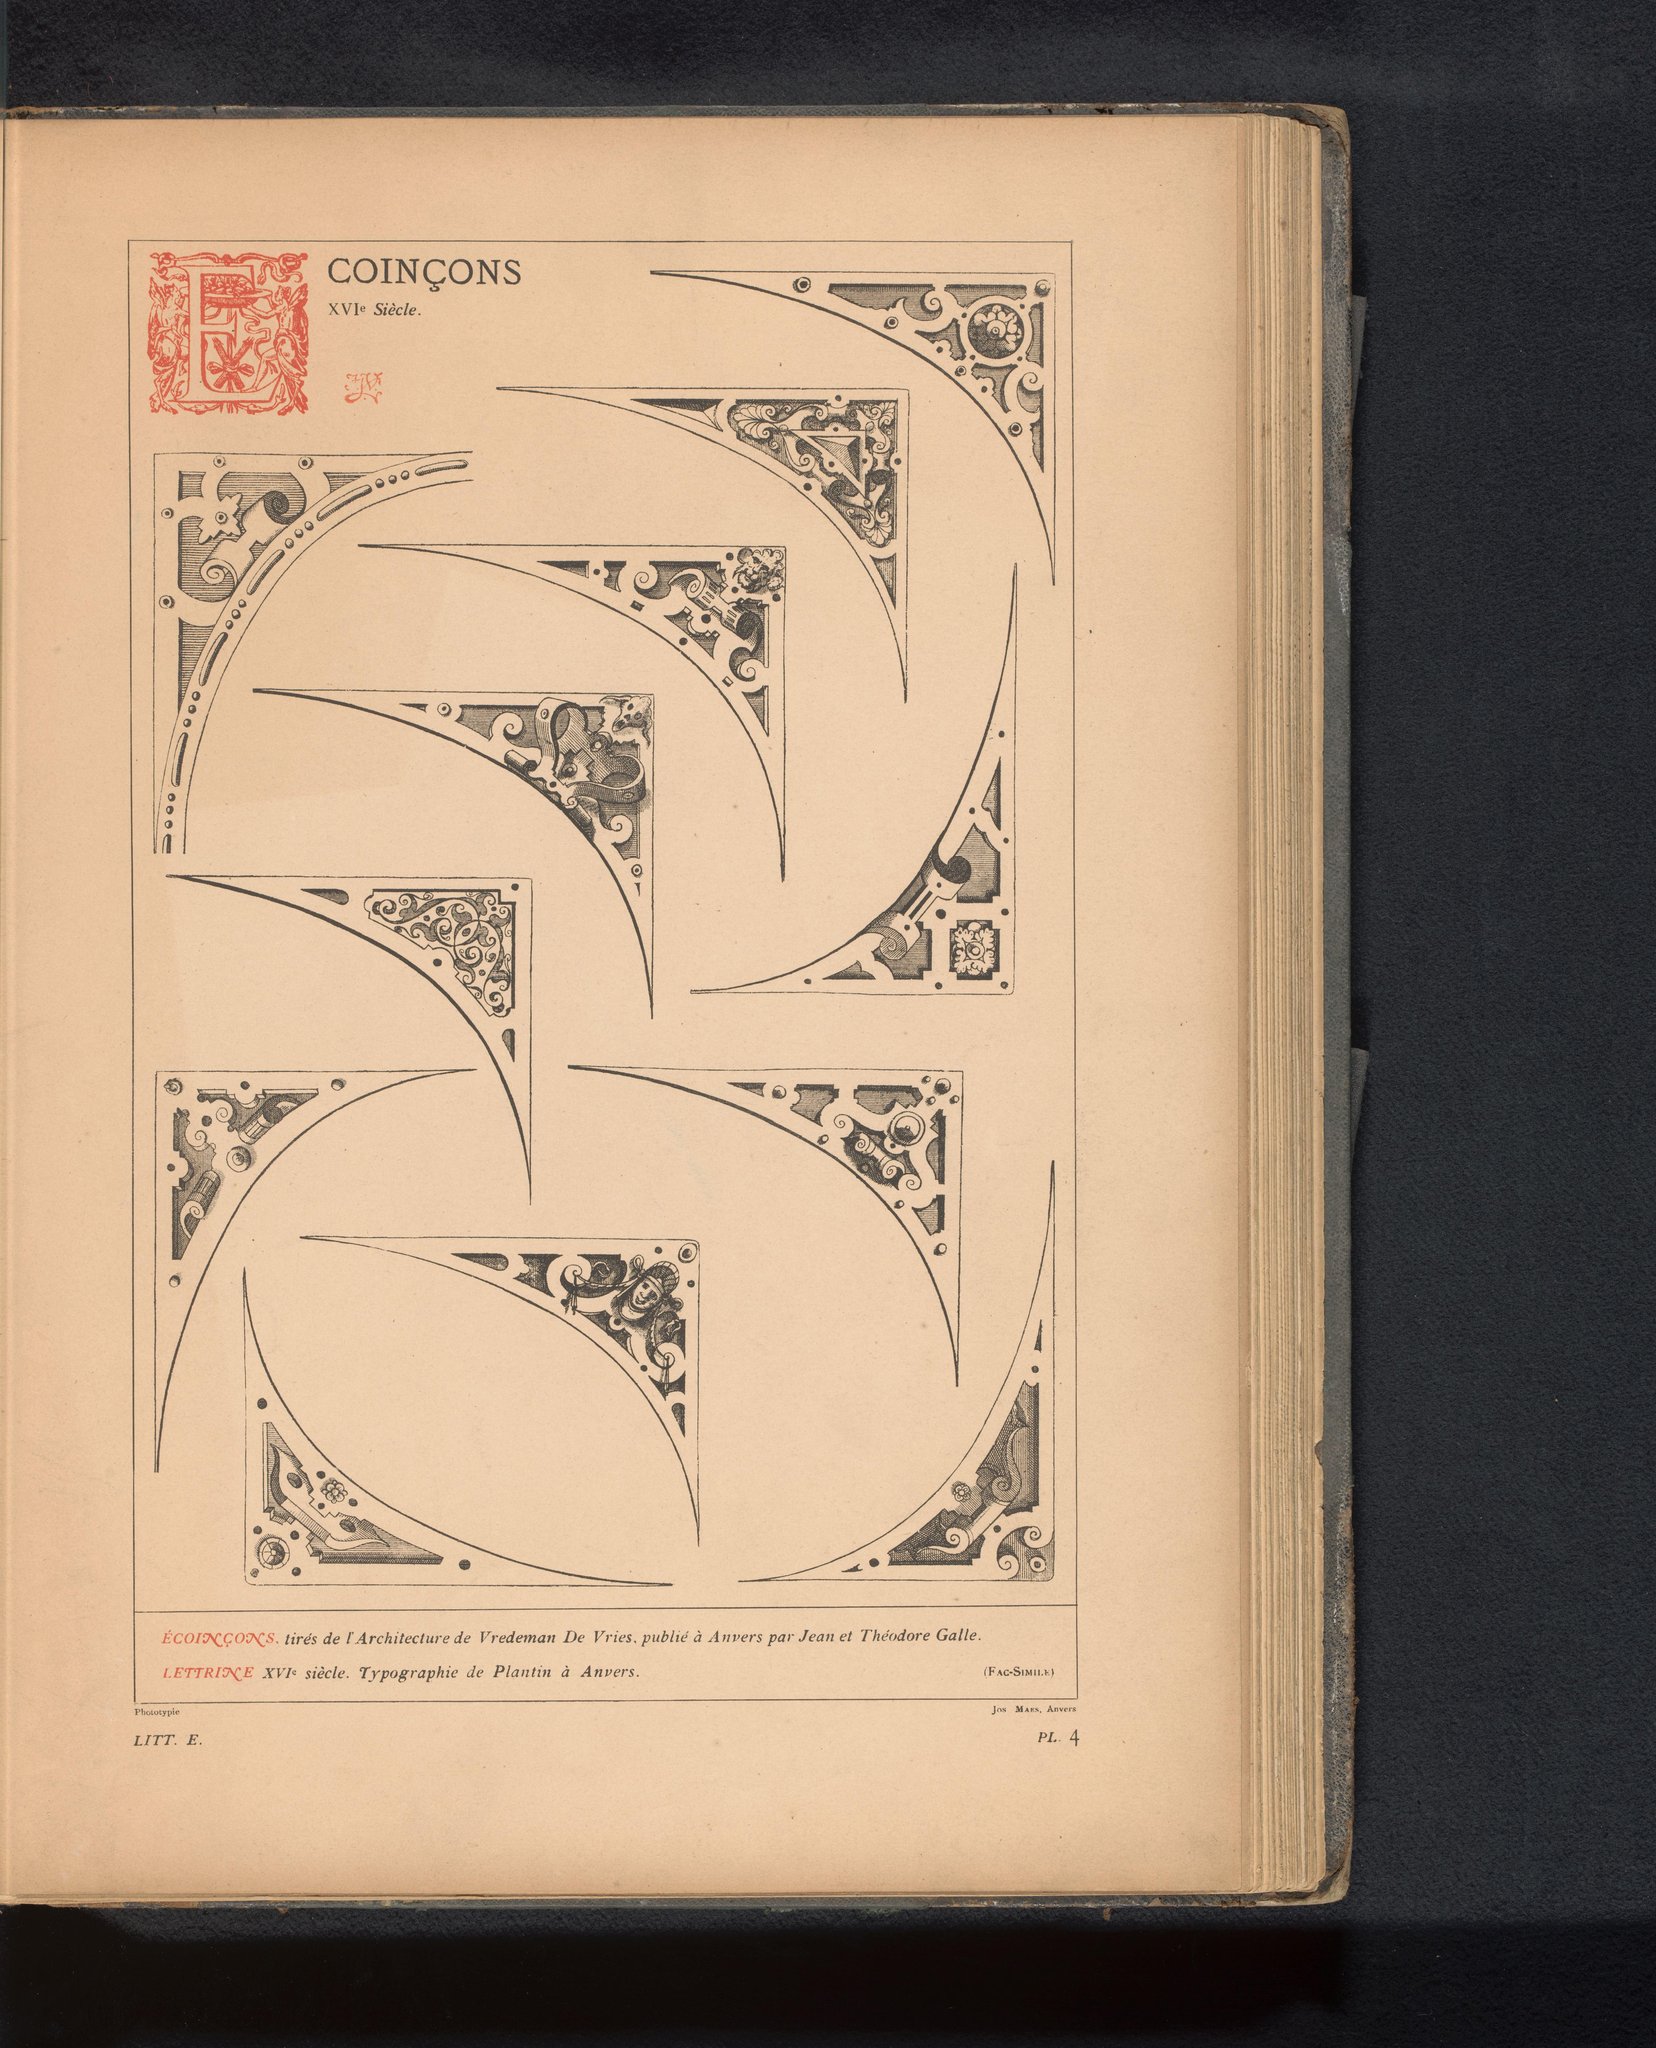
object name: reproduction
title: Reproductie van een prent van twaalf gedecoreerde hoeken uit de Architecture door Hans Vredeman de Vries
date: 1875-1880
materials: paper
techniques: photolithography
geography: antwerp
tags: ornament derived from architectural details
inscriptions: inscription: ‘LITT. E. - PL. 4’, monogram: ‘JJvY’, inscription: ‘ÉCOINÇONS tirés de (...)’